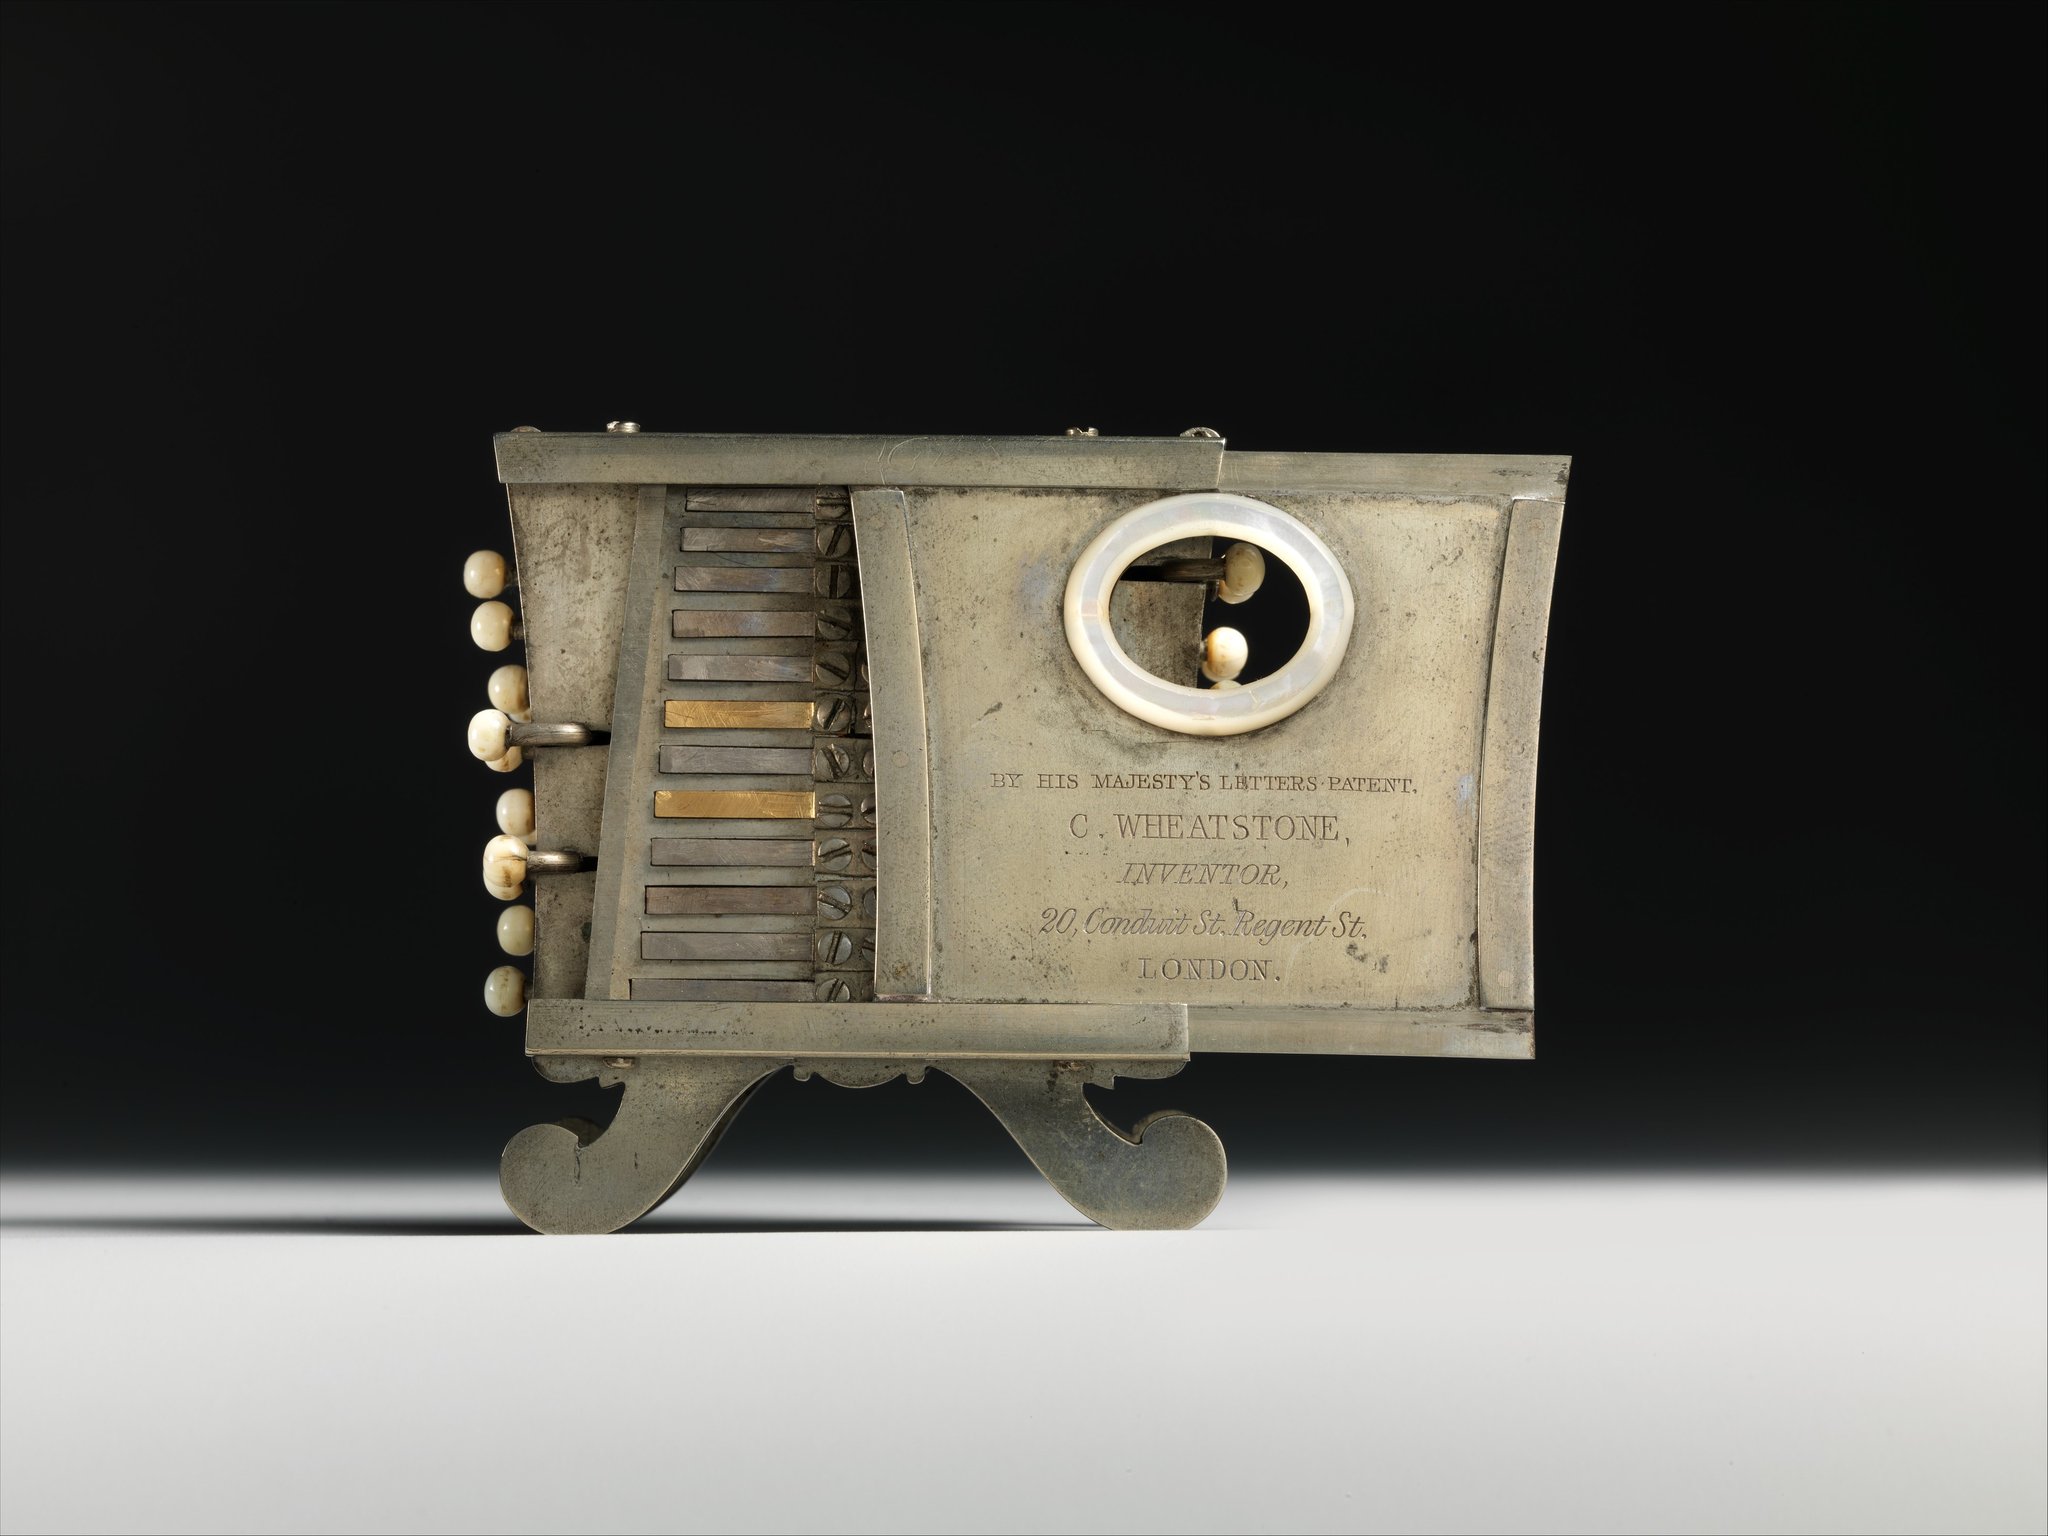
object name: symphonium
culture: british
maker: charles wheatstone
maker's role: maker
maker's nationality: british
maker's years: 1802-1875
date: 1835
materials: brass, ivory, mother of pearl, nickel, silver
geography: united kingdom